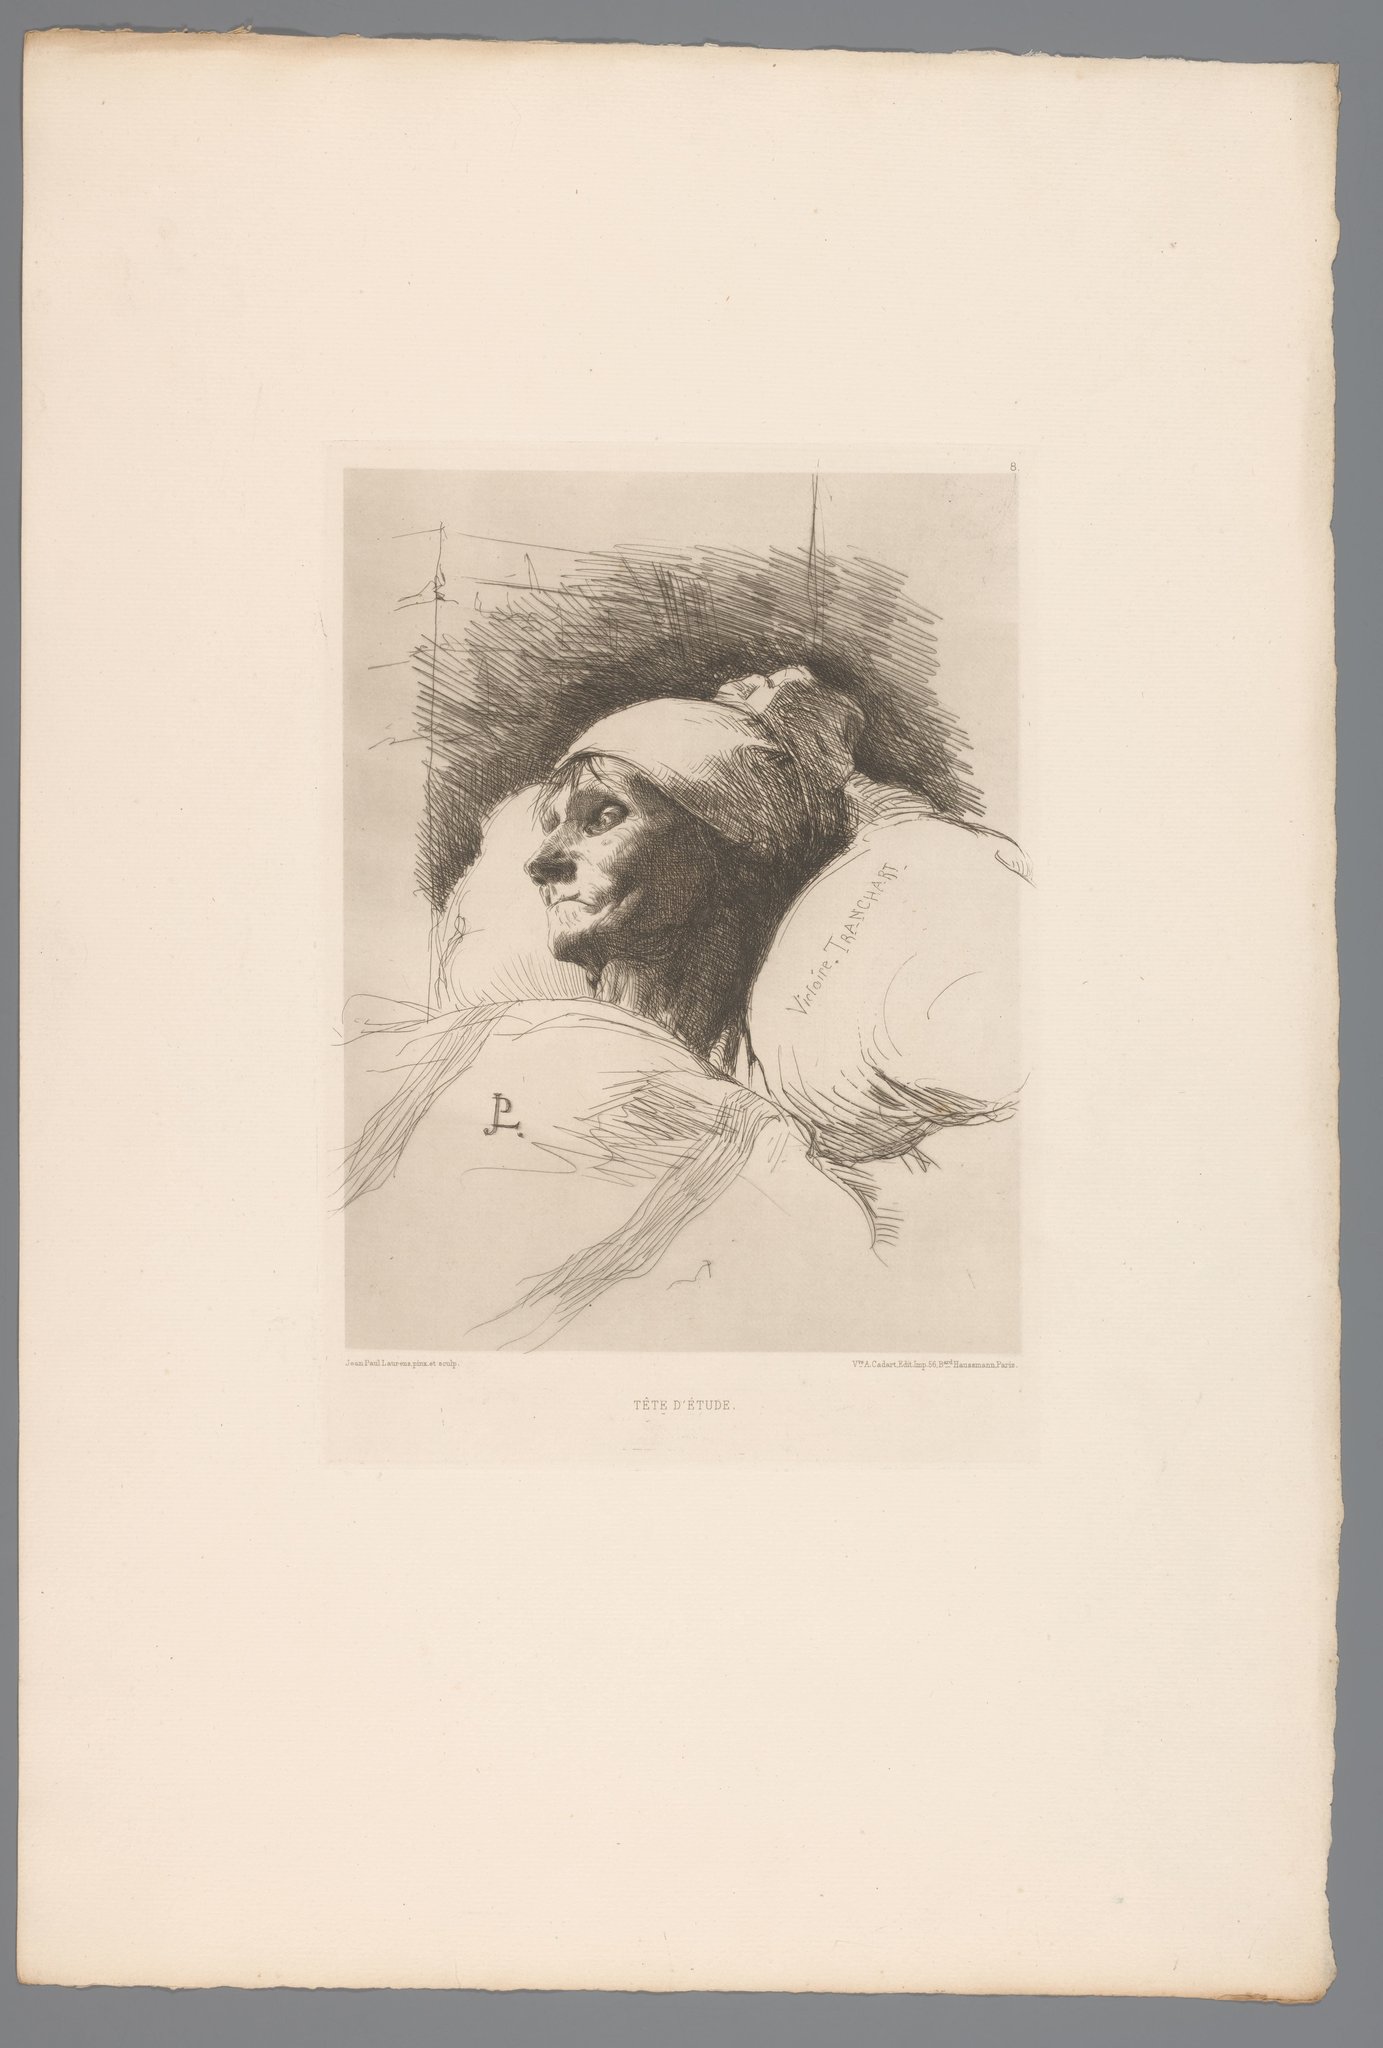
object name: print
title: Franse etsen uit 1877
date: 1877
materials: paper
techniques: drypoint, etching, intaglio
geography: paris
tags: historical persons - bb - woman, deathbed, old woman, lying figure - aa - female human figure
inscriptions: collector's mark: ‘AFE v S’, collector's mark: Lugt 2228, collector's mark: Lugt 2760